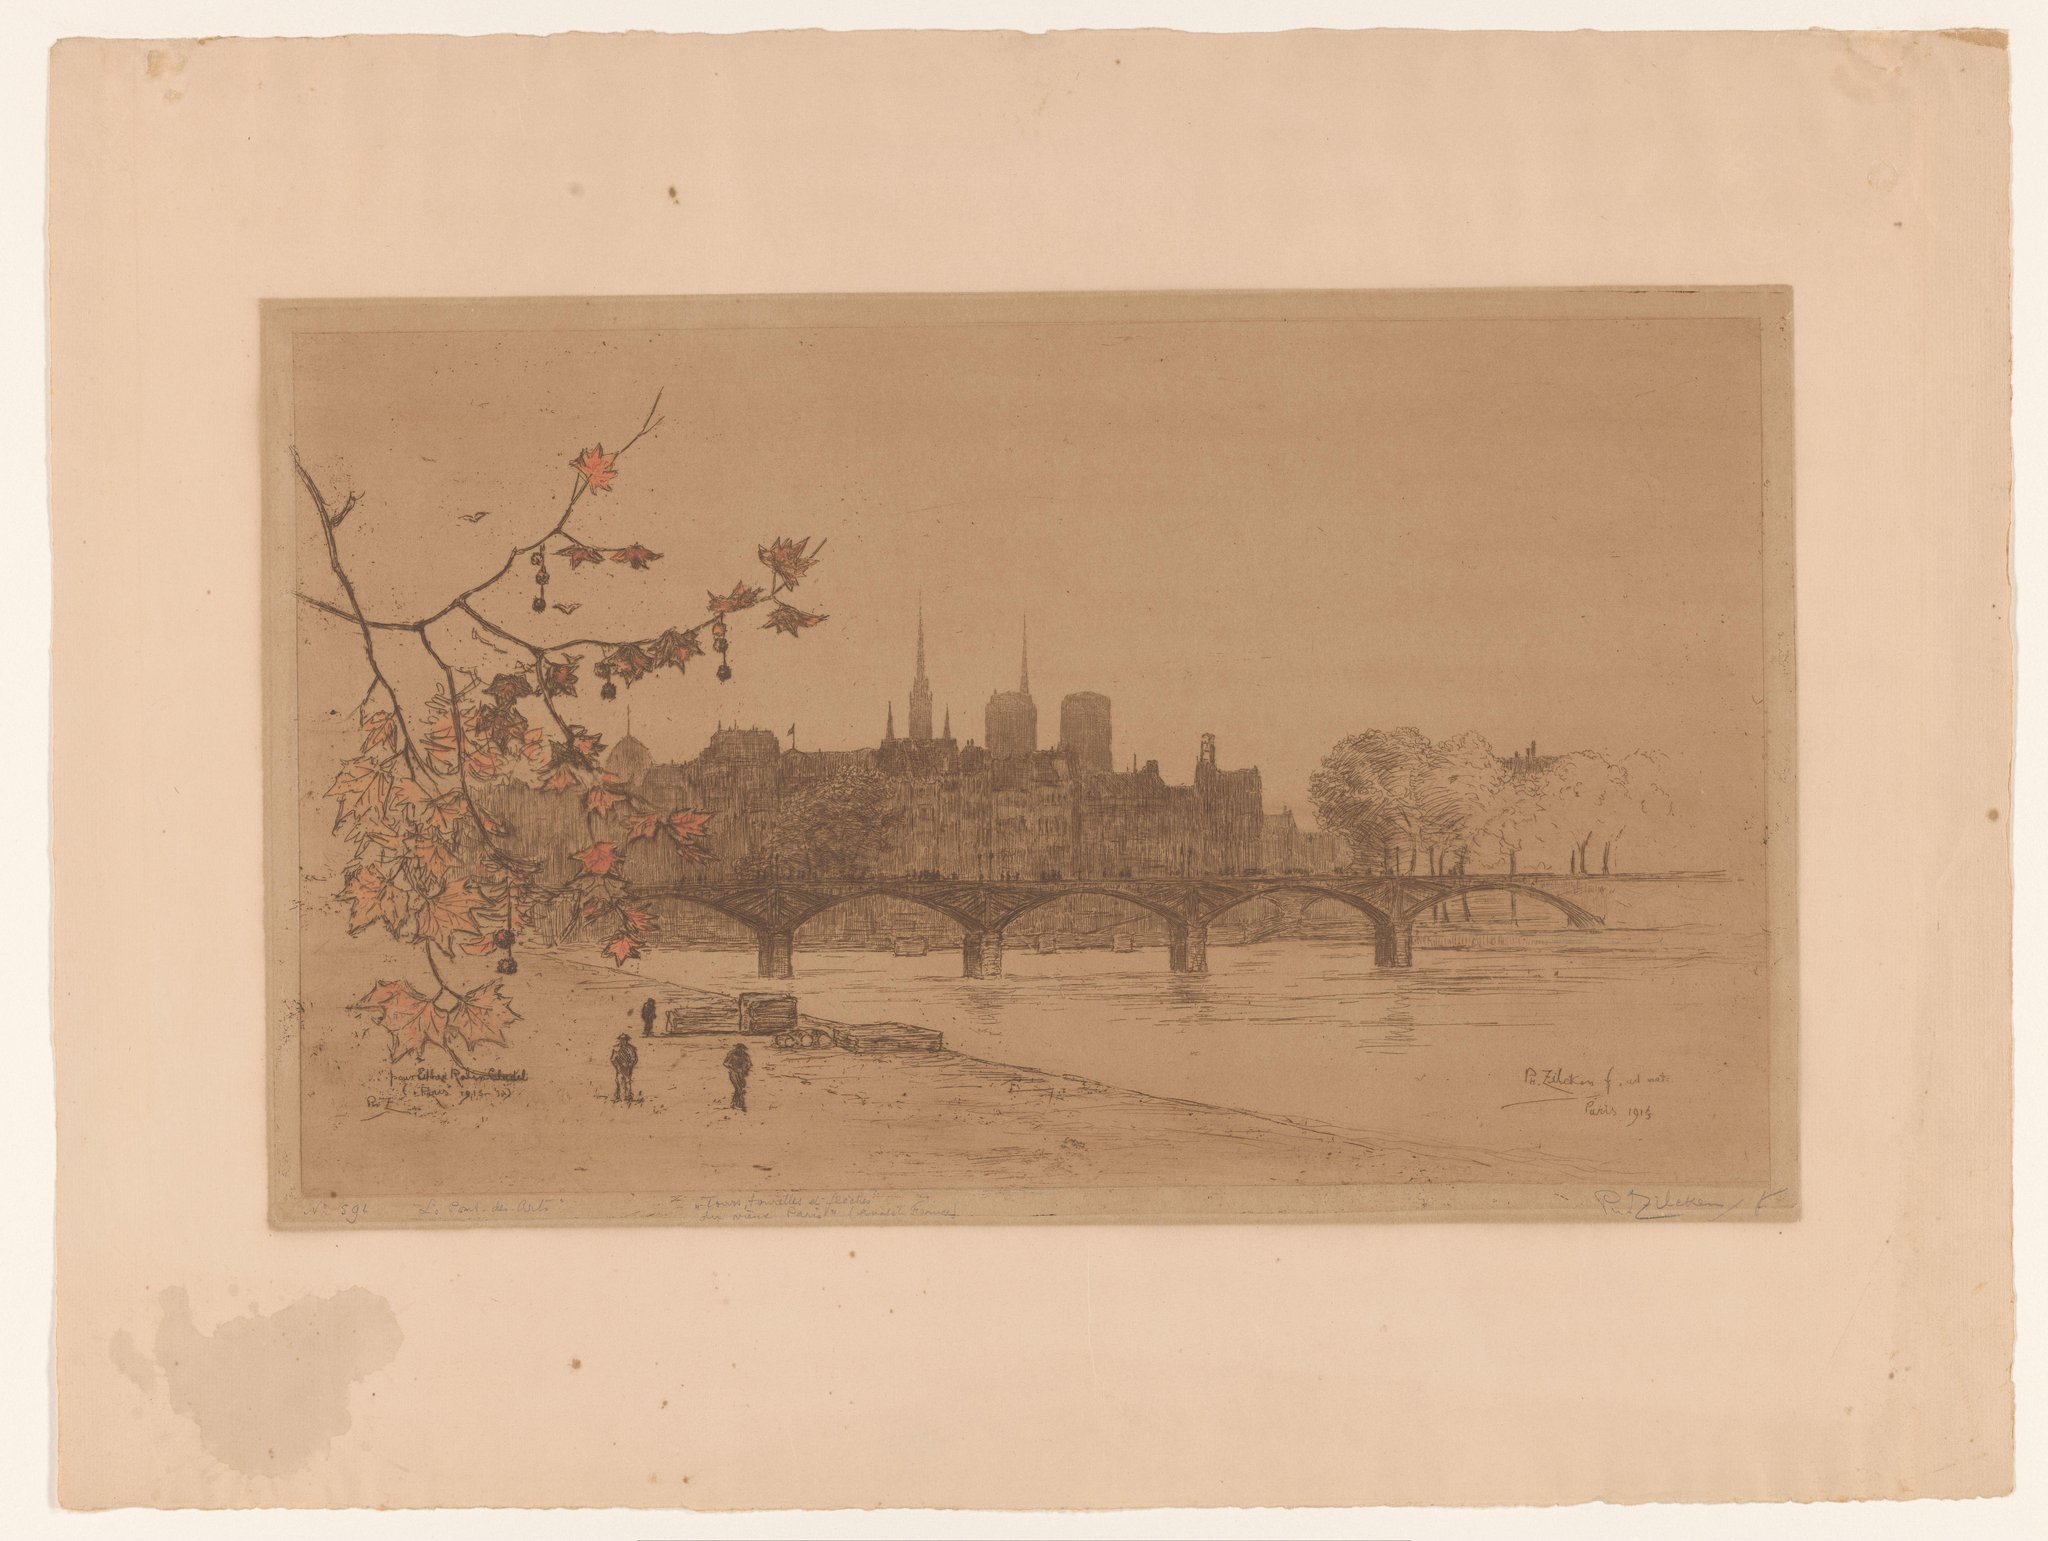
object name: print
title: Gezicht op Parijs over de Pont des Arts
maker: philip zilcken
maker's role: draughtsman, painter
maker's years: 1857-1930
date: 1914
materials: paper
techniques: etching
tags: bridge in city across river, canal, etc., parts of church exterior and annexes: tower, paris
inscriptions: collector's mark: Lugt 2760, inscription: ‘No. 596’, collector's mark: Lugt 2228, dedication: ‘'pour Esther Rolin Cladel/ (Paris 1913-'14)'’, inscription: ‘'Tours. tourelles et flèches/ du vieux Paris' (Anatole France)’